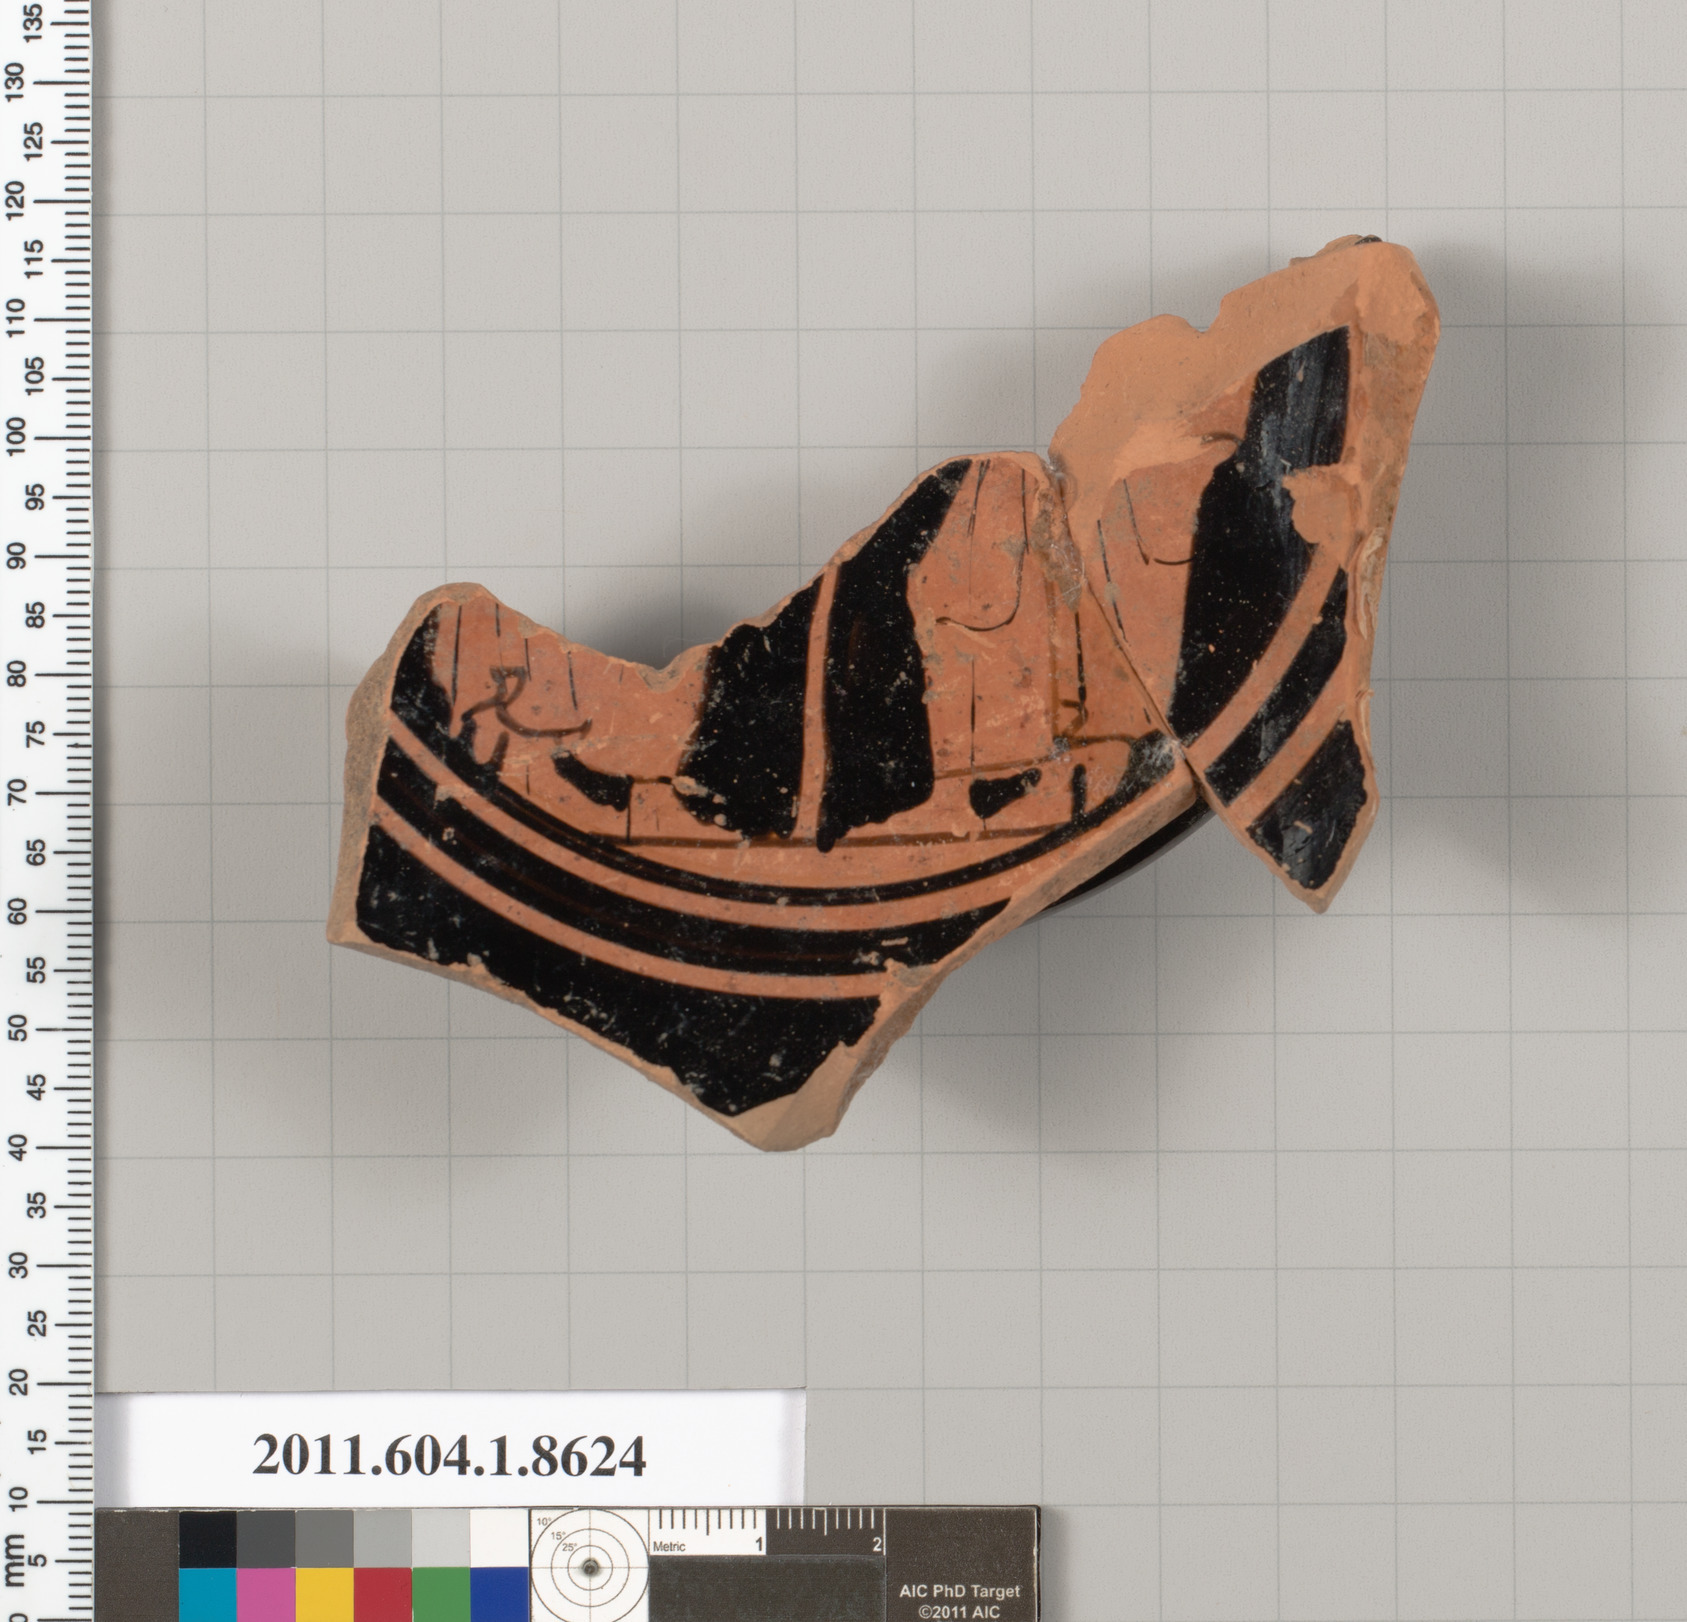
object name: kylix fragment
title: Terracotta fragment of a stemless kylix (drinking cup)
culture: greek, attic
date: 460-450 BCE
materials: terracotta